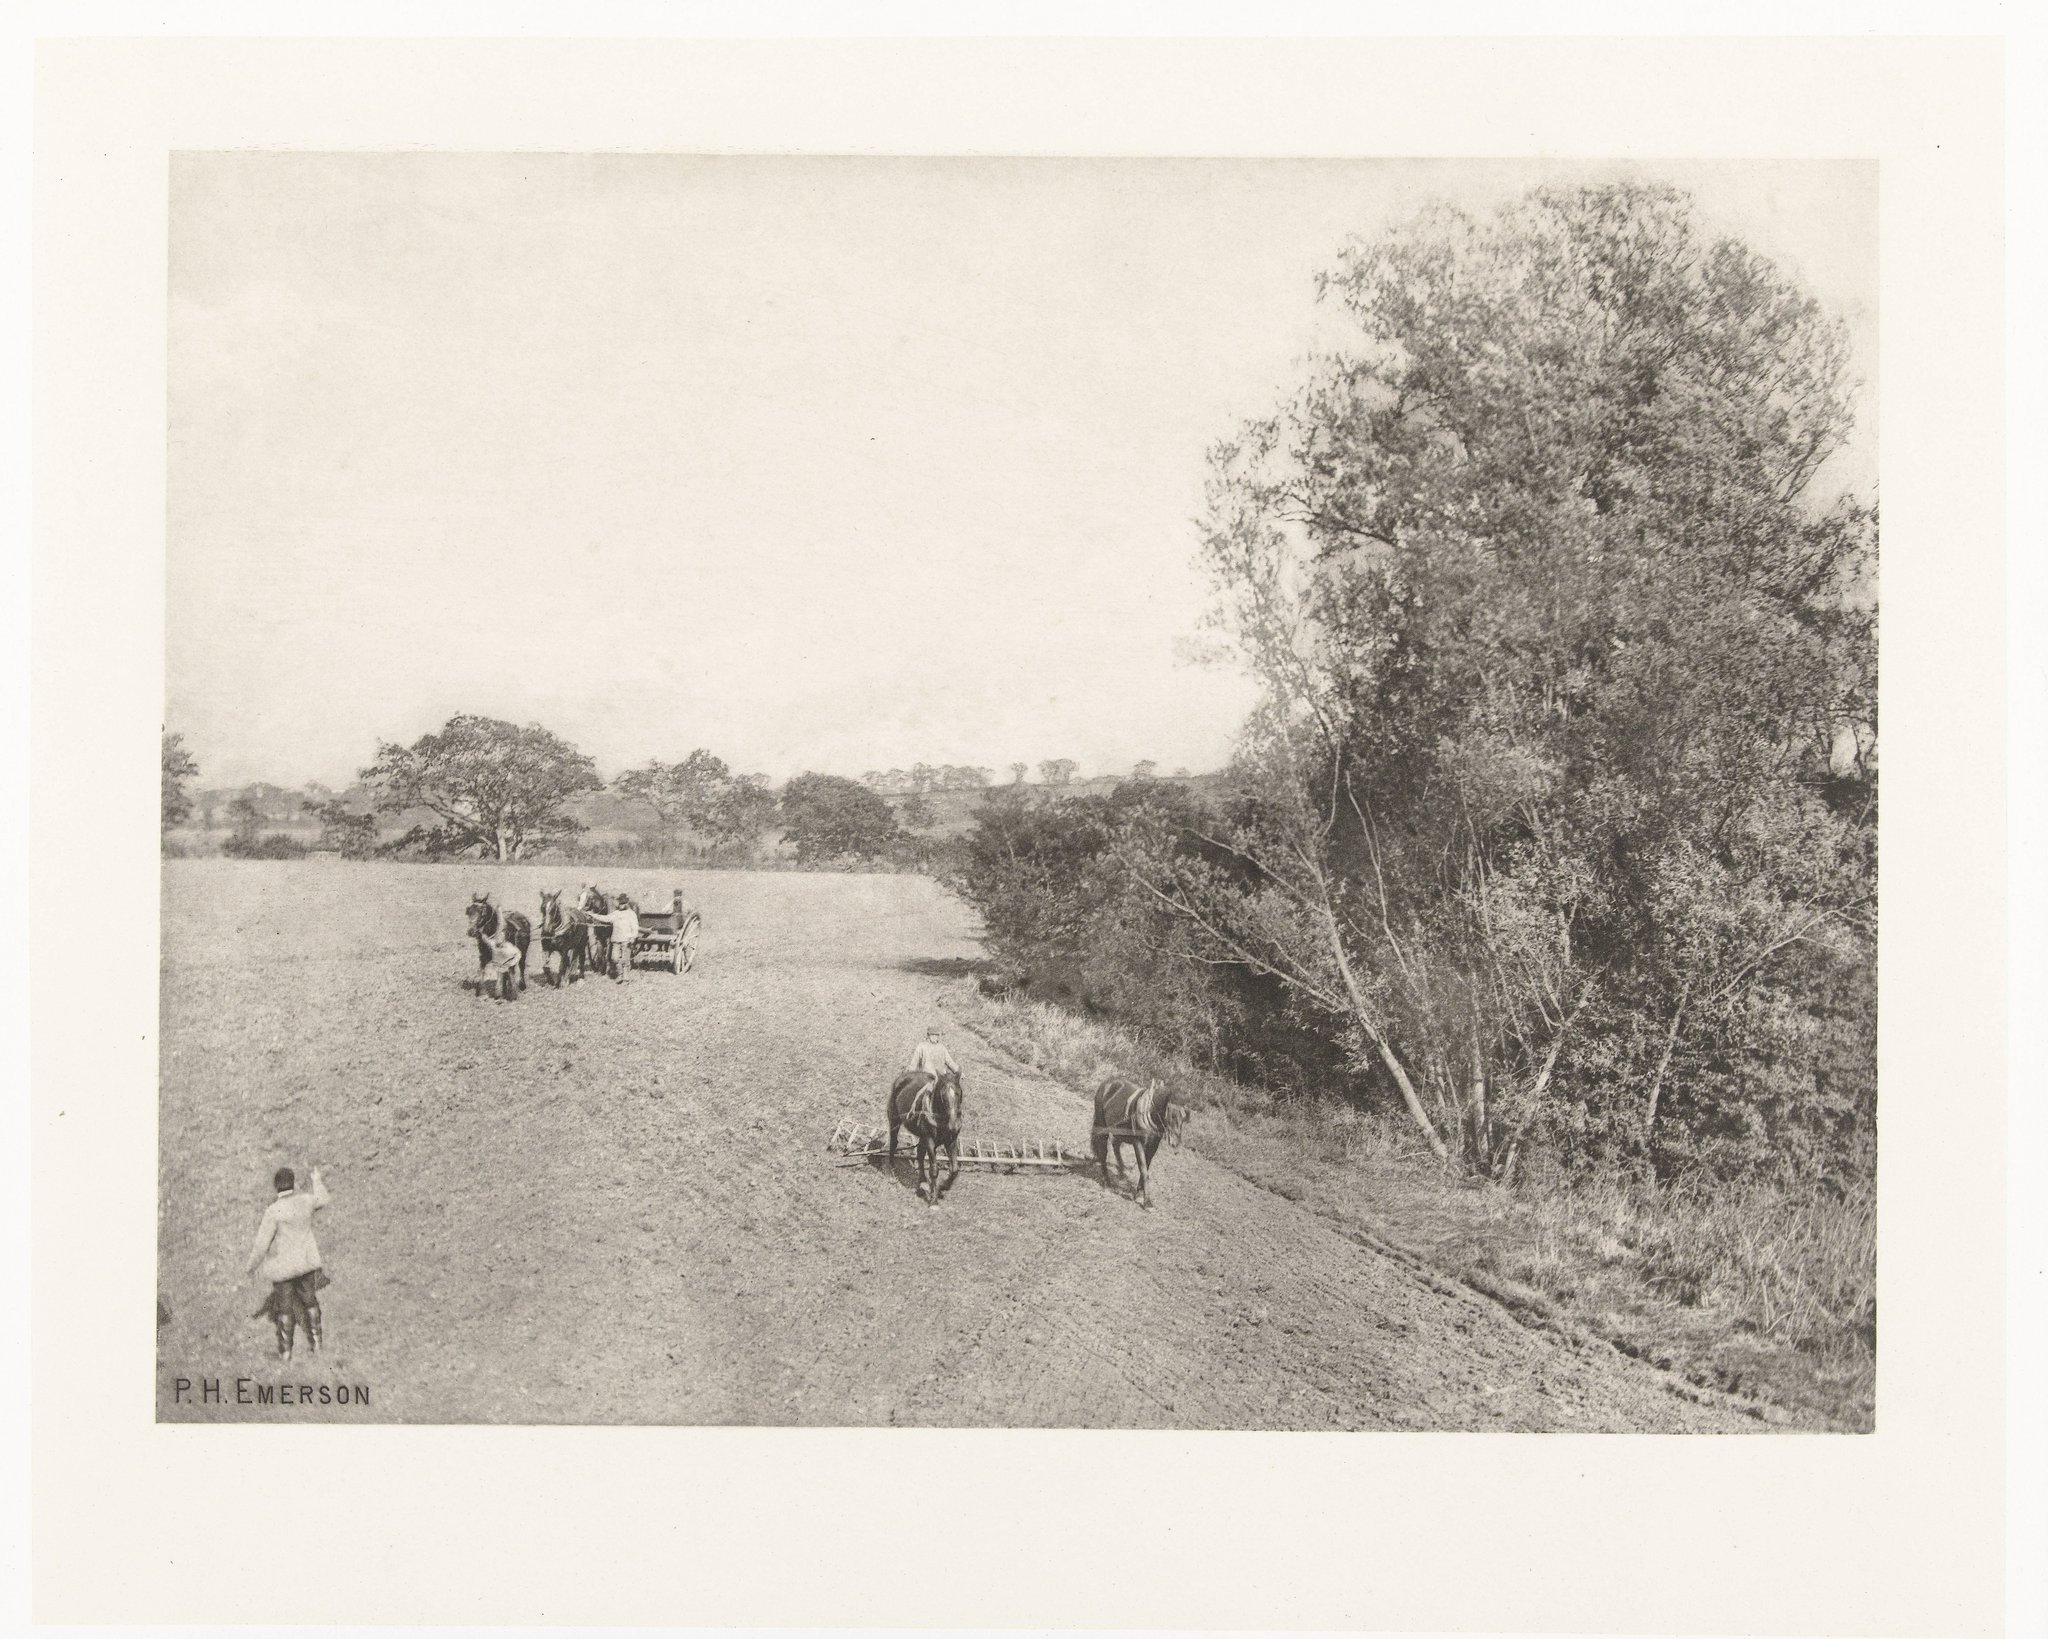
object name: photomechanical print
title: In the Barley-Sele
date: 1884-1887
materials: cardboard, paper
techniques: photoaquatint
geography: london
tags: horse, ploughing, great britain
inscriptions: inscription: ‘ploughing’, number: ‘18’